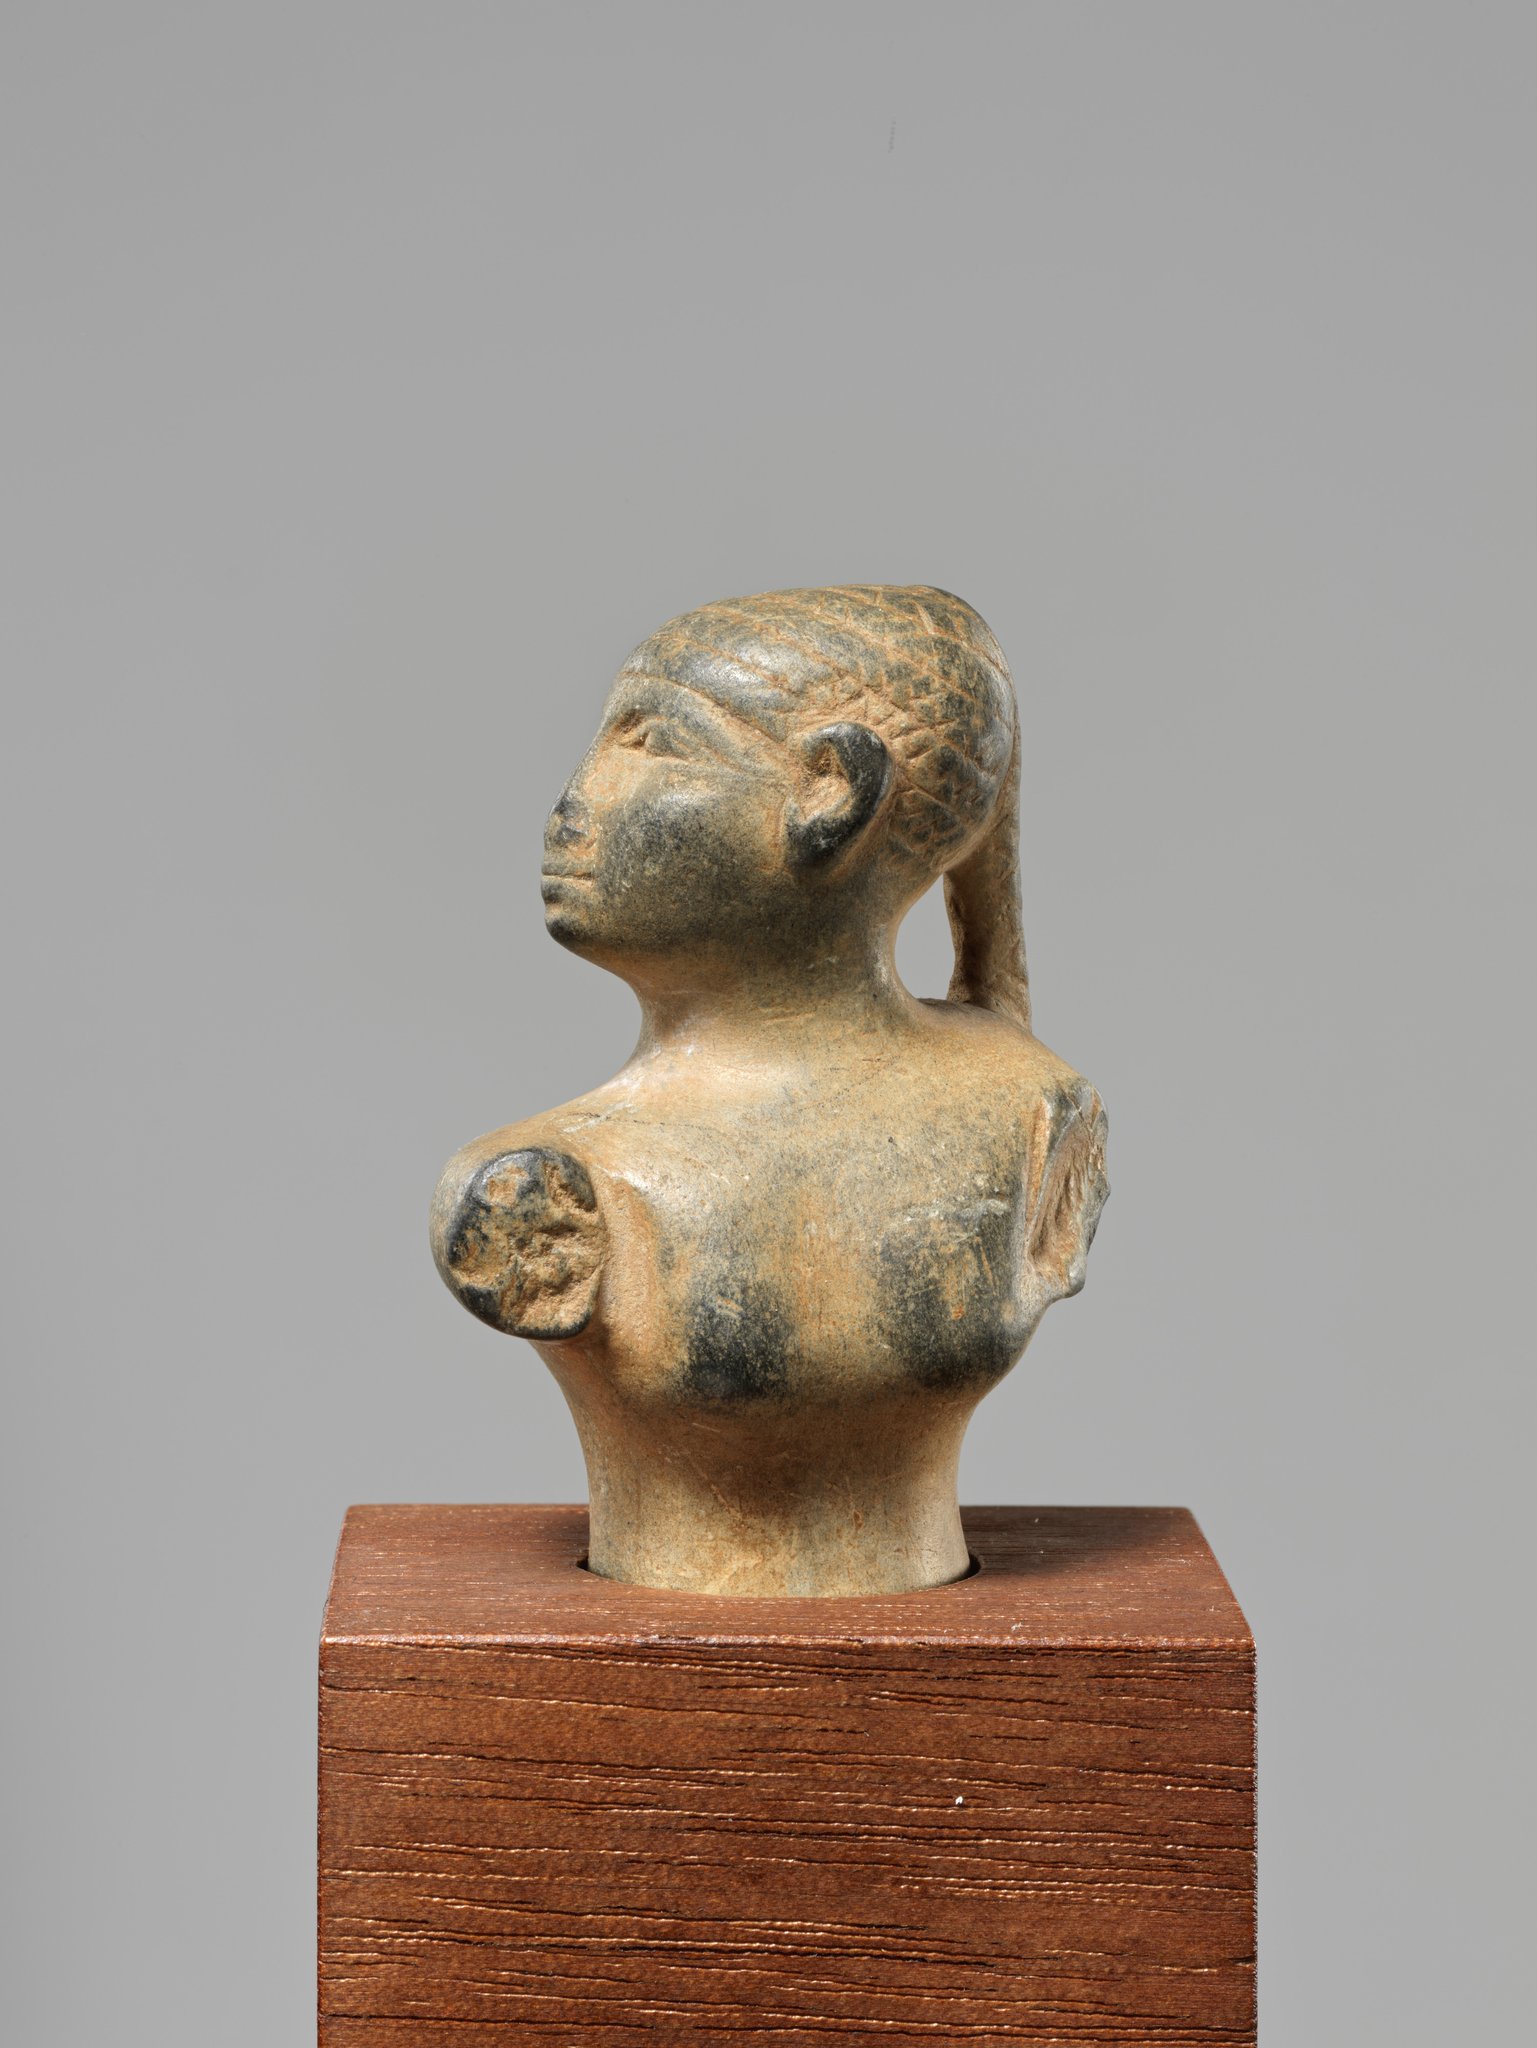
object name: statue, figurine, braid, foreigner, servant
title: Statuette of a female figure with a braid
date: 1802-1650 BCE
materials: stone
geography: egypt